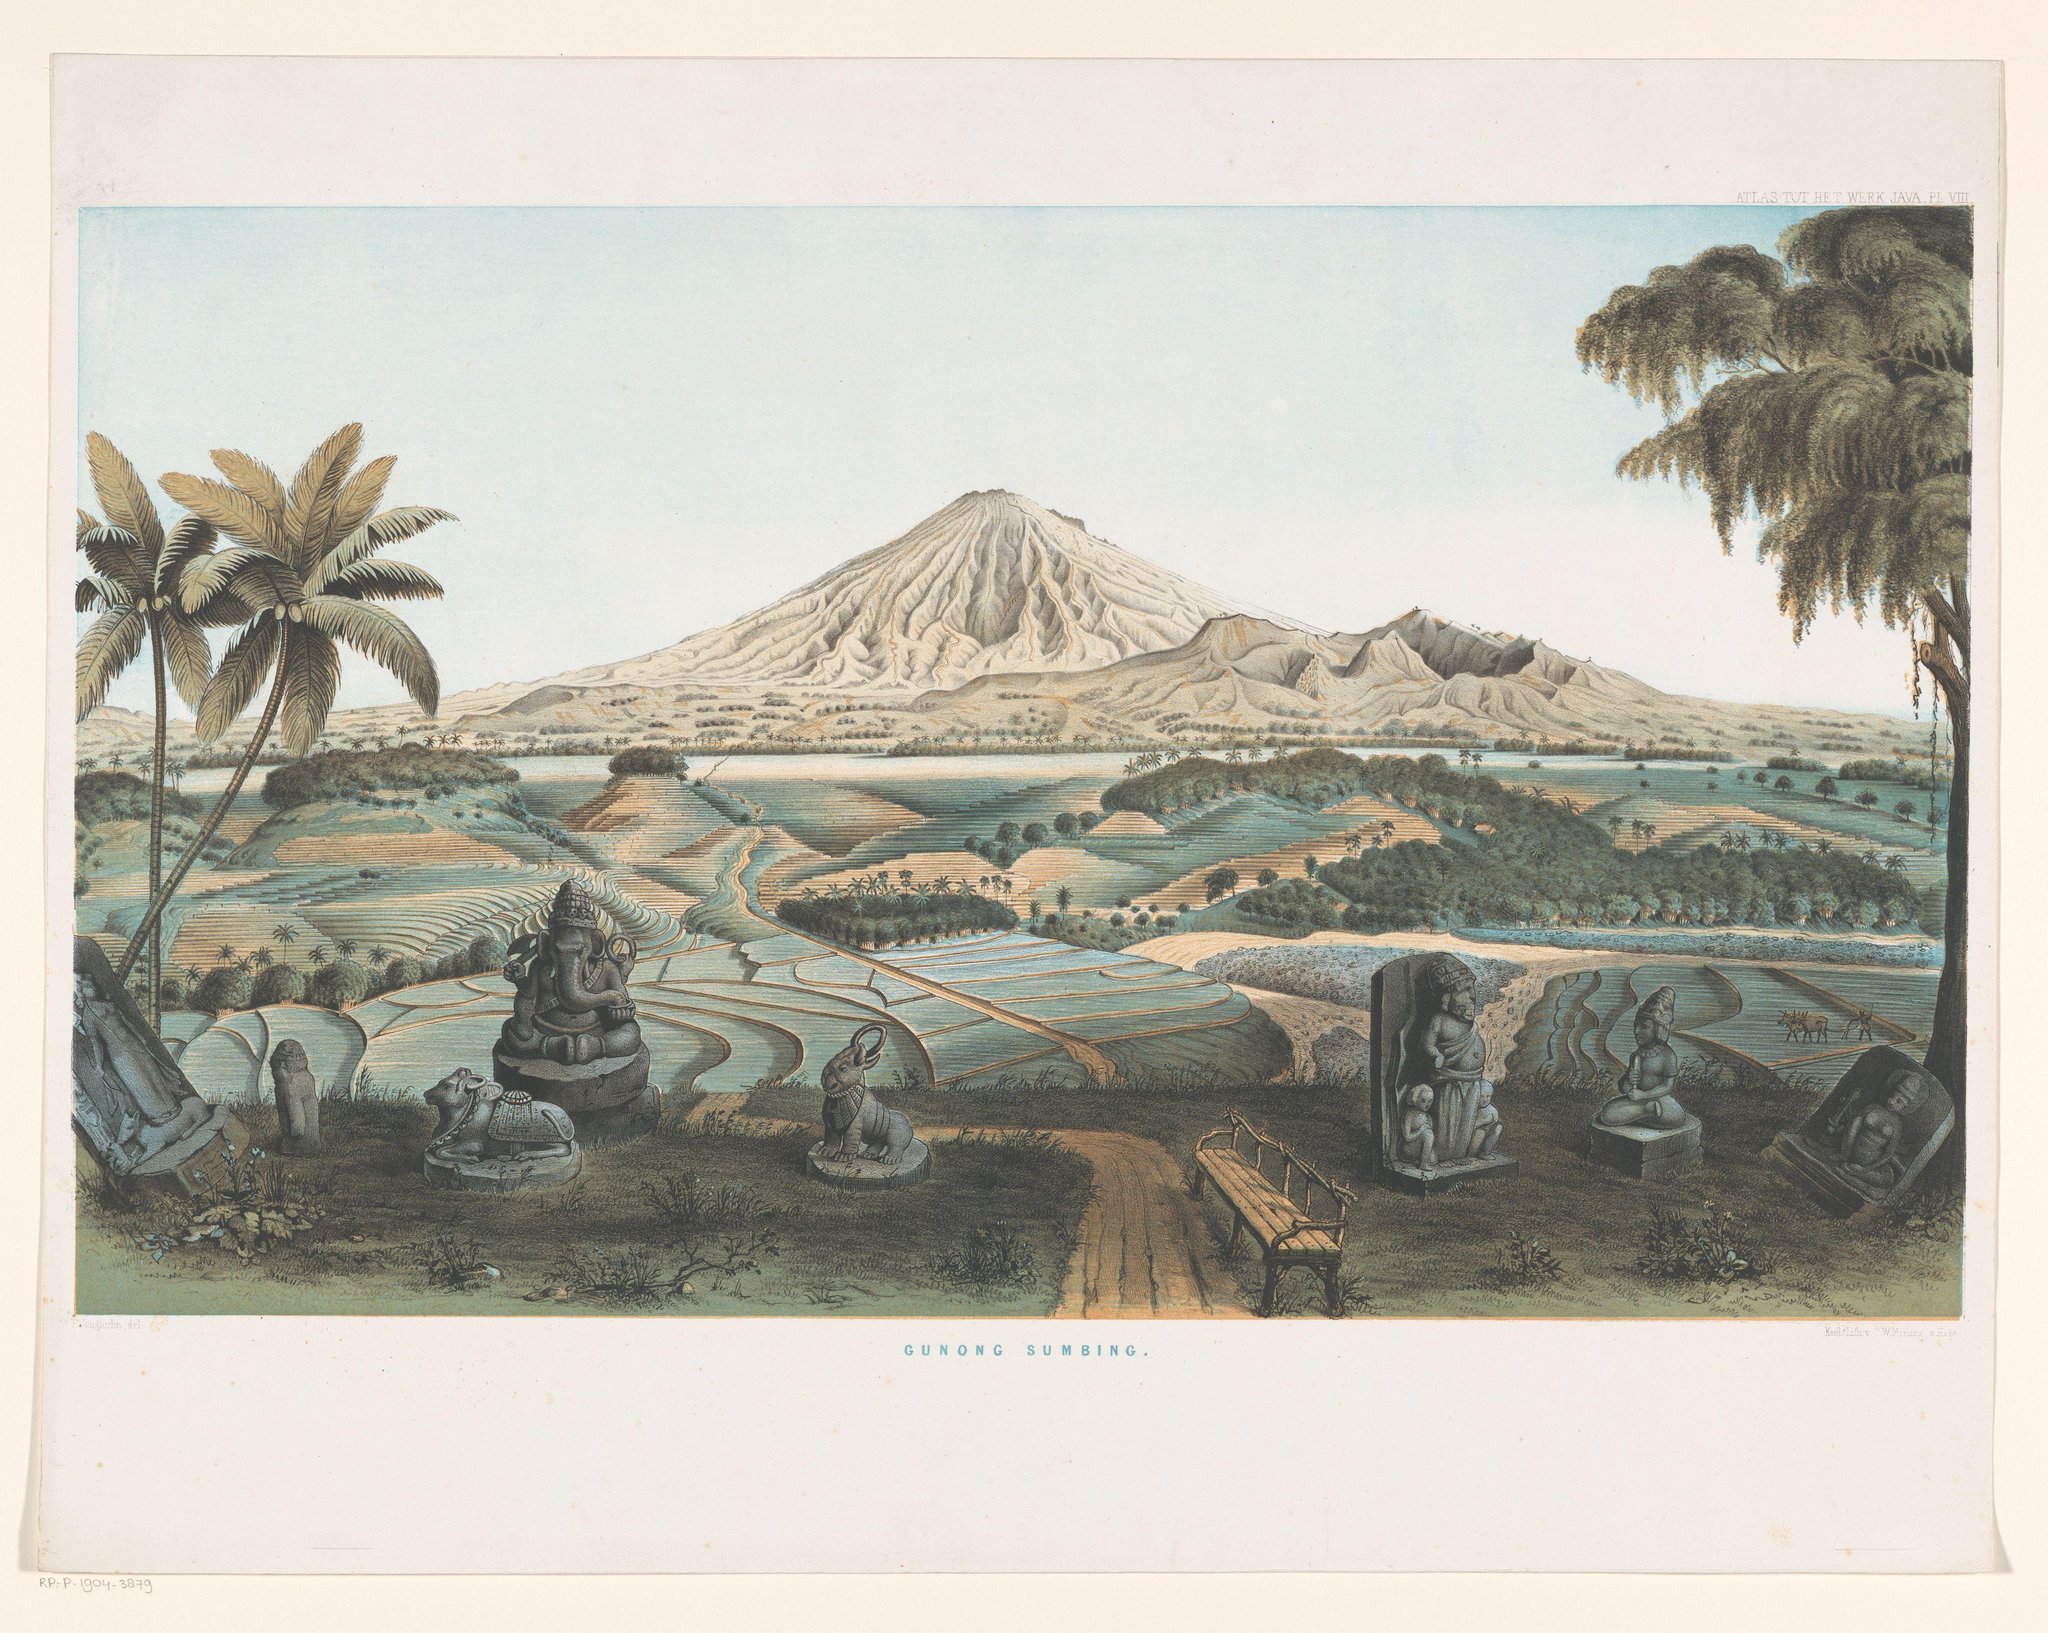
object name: print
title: Vulkaan Sumbing te Java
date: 1854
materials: paper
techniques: lithograph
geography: the hague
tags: statues, paintings, etc. ~ objects of worship (hinduism, buddhism, jainism) - hh - in the open air, landscapes in the non-temperate zone, exotic landscapes, volcano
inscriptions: collector's mark: Lugt 2228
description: Onderdeel van een serie van elf, bedoeld als aanvulling op: Junghuhn, Franz. Java: zijne gedaante, zijn plantentooi en inwendige bouw. 4 delen. Den Haag: Carl Wilheml Mieling, 1853-1854. Zie ook RP-P-1904-3883 (ander kleurenpalet).